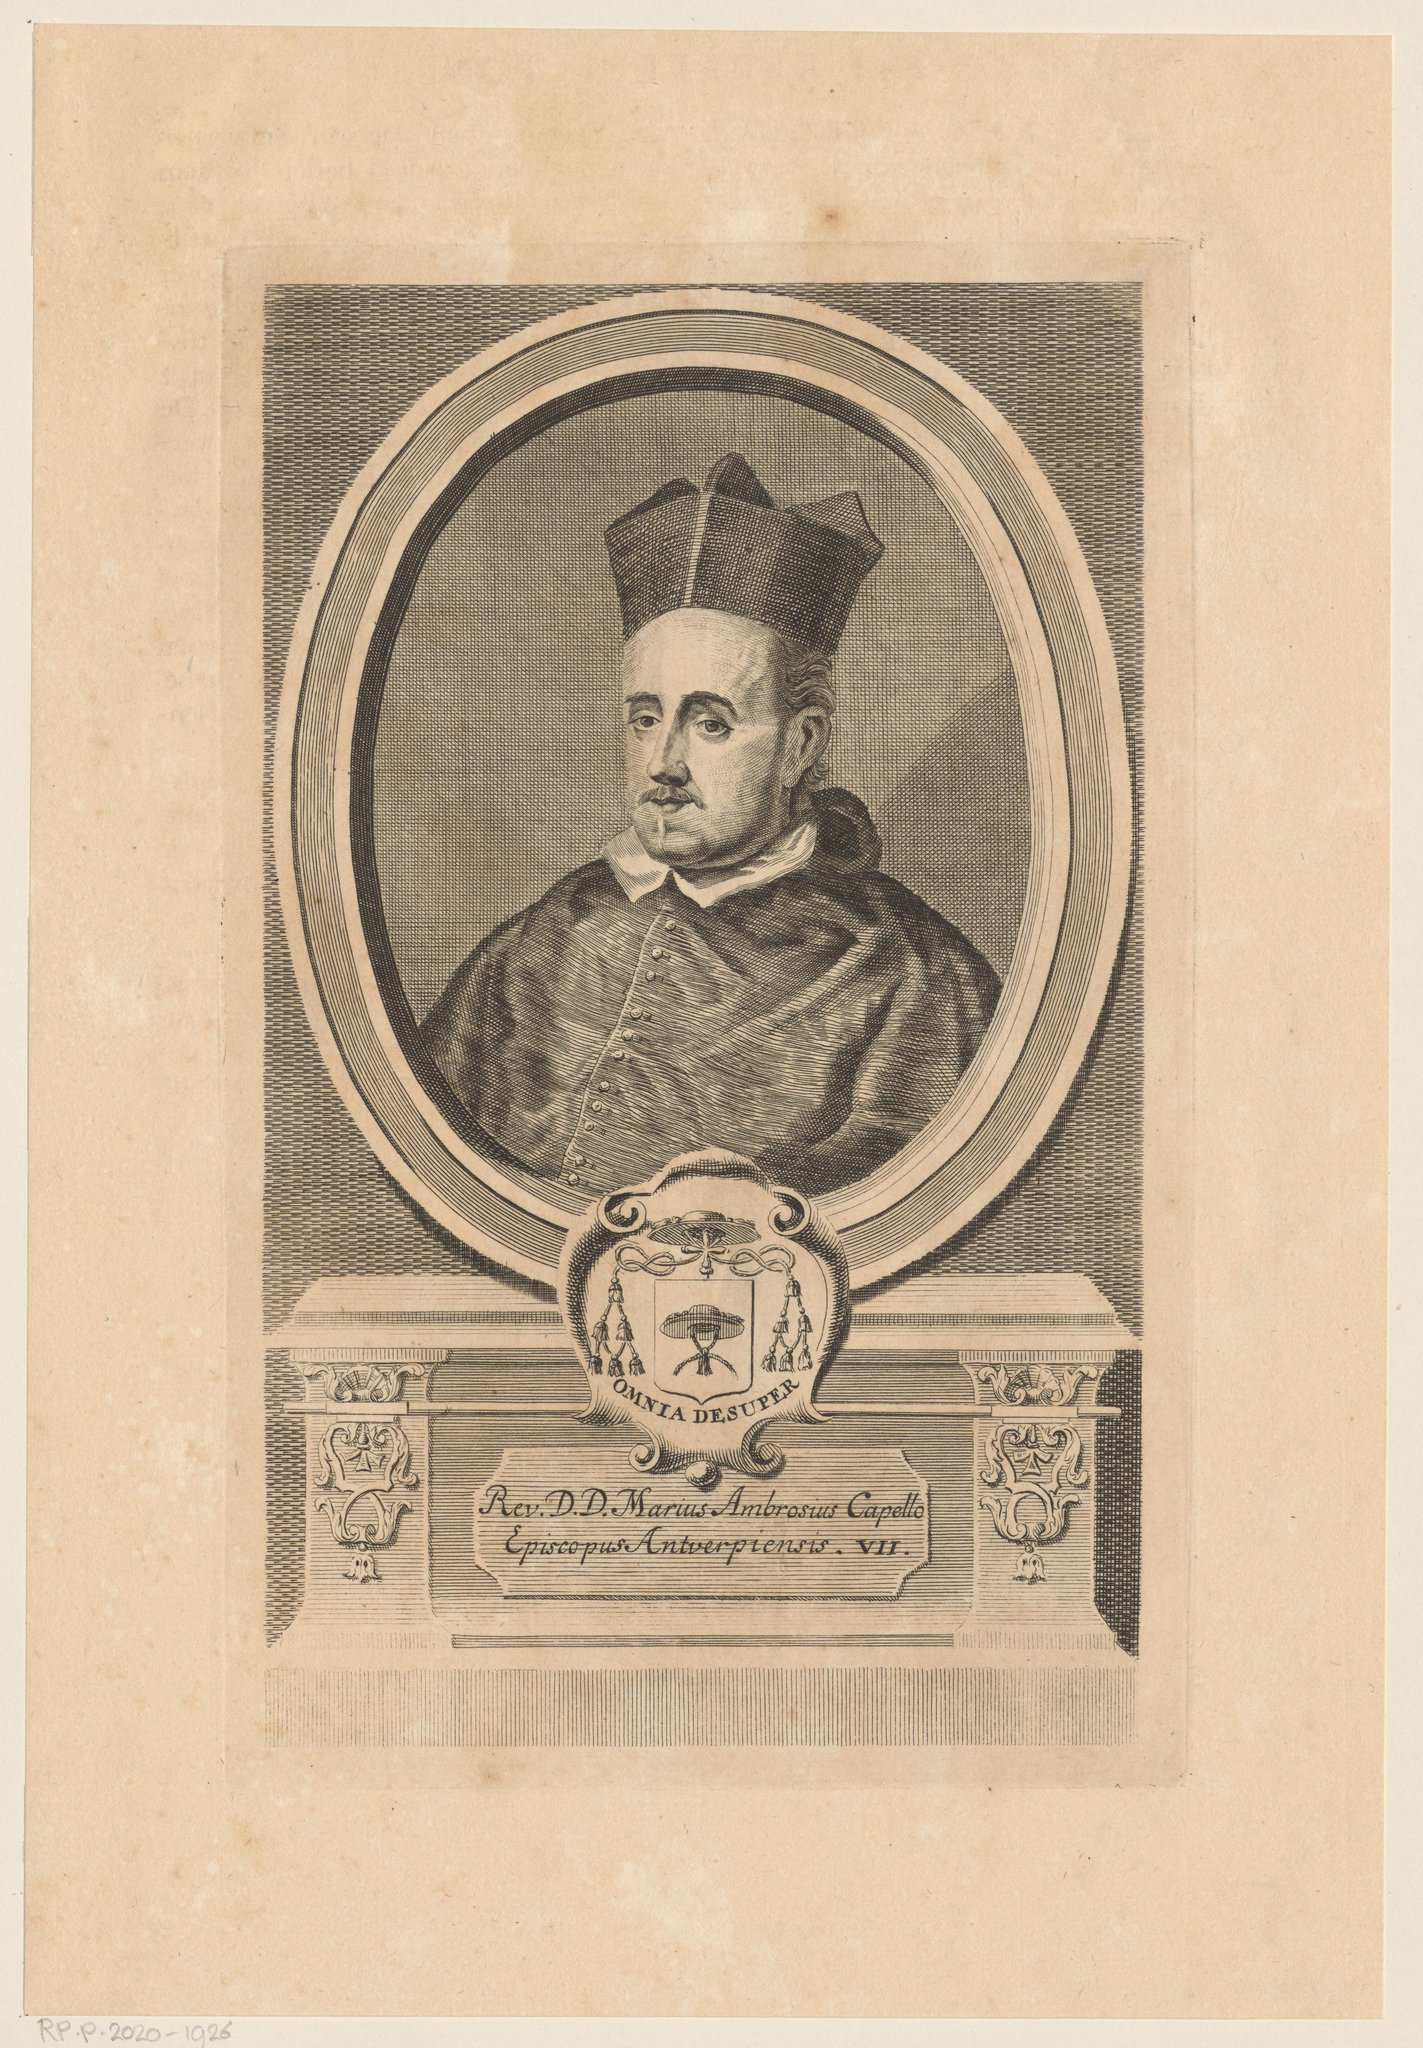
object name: print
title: Portret van Marius Ambrosius Capello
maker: jan baptist jongelinx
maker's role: print maker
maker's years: 1689-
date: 1727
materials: paper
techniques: engraving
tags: antwerp, marius ambrosius capello, archbishop, bishop, etc. (roman catholic), historical persons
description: Prent mogelijk uit: Roy, Jacobus le. Groot kerkelijk toneel des hertogdoms van Brabant (...). Den Haag: Christiaan van Lom, 1727.